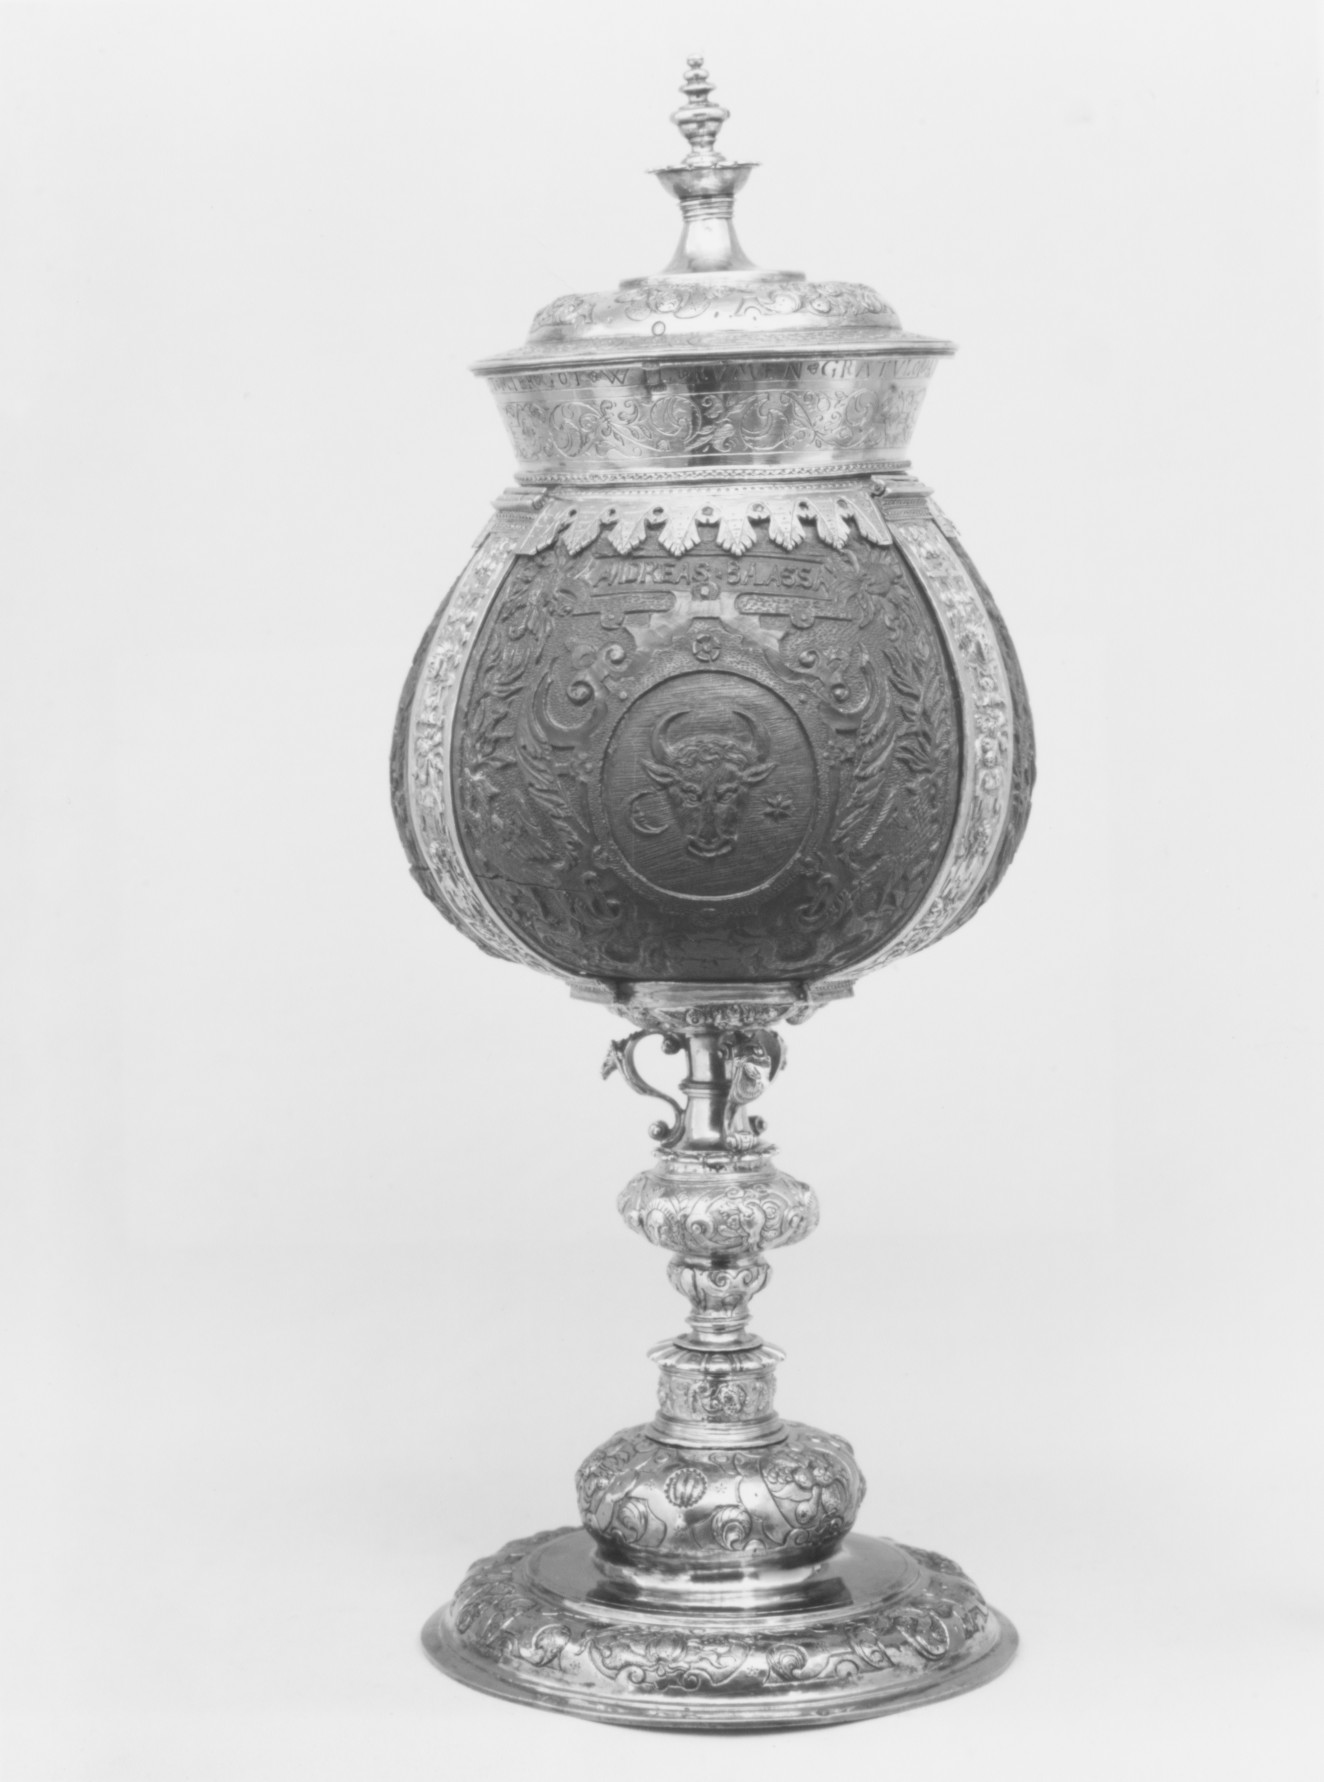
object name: standing cup with cover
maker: hans wendel pensel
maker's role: maker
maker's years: 1591-1602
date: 1567-1633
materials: silver gilt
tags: animals,bulls